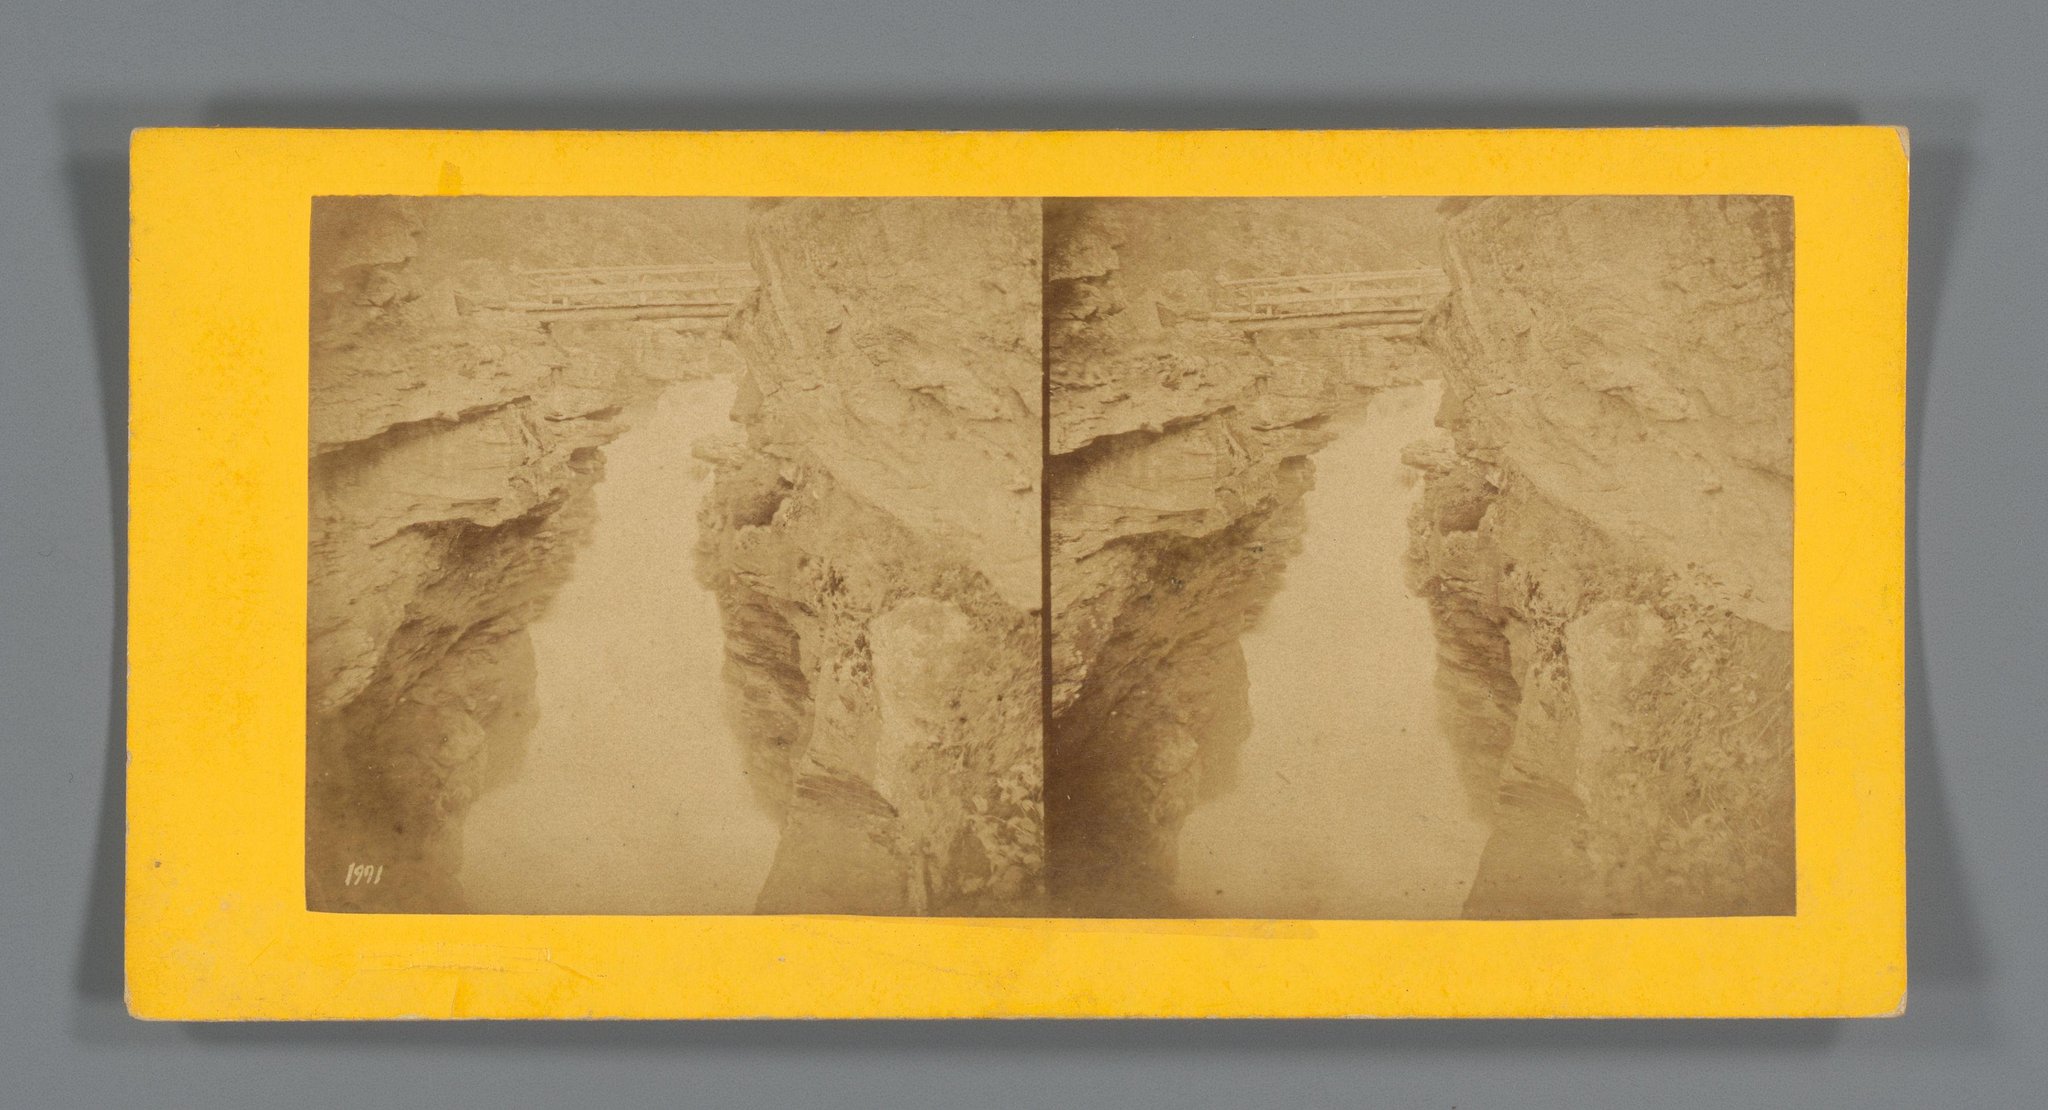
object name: stereograph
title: Norge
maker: knud knudsen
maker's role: fotograaf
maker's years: 1832-1915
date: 1861-1870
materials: cardboard, paper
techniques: albumen print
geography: romsdalen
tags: waterfall, bridge, boulder, stone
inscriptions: number: ‘1991’